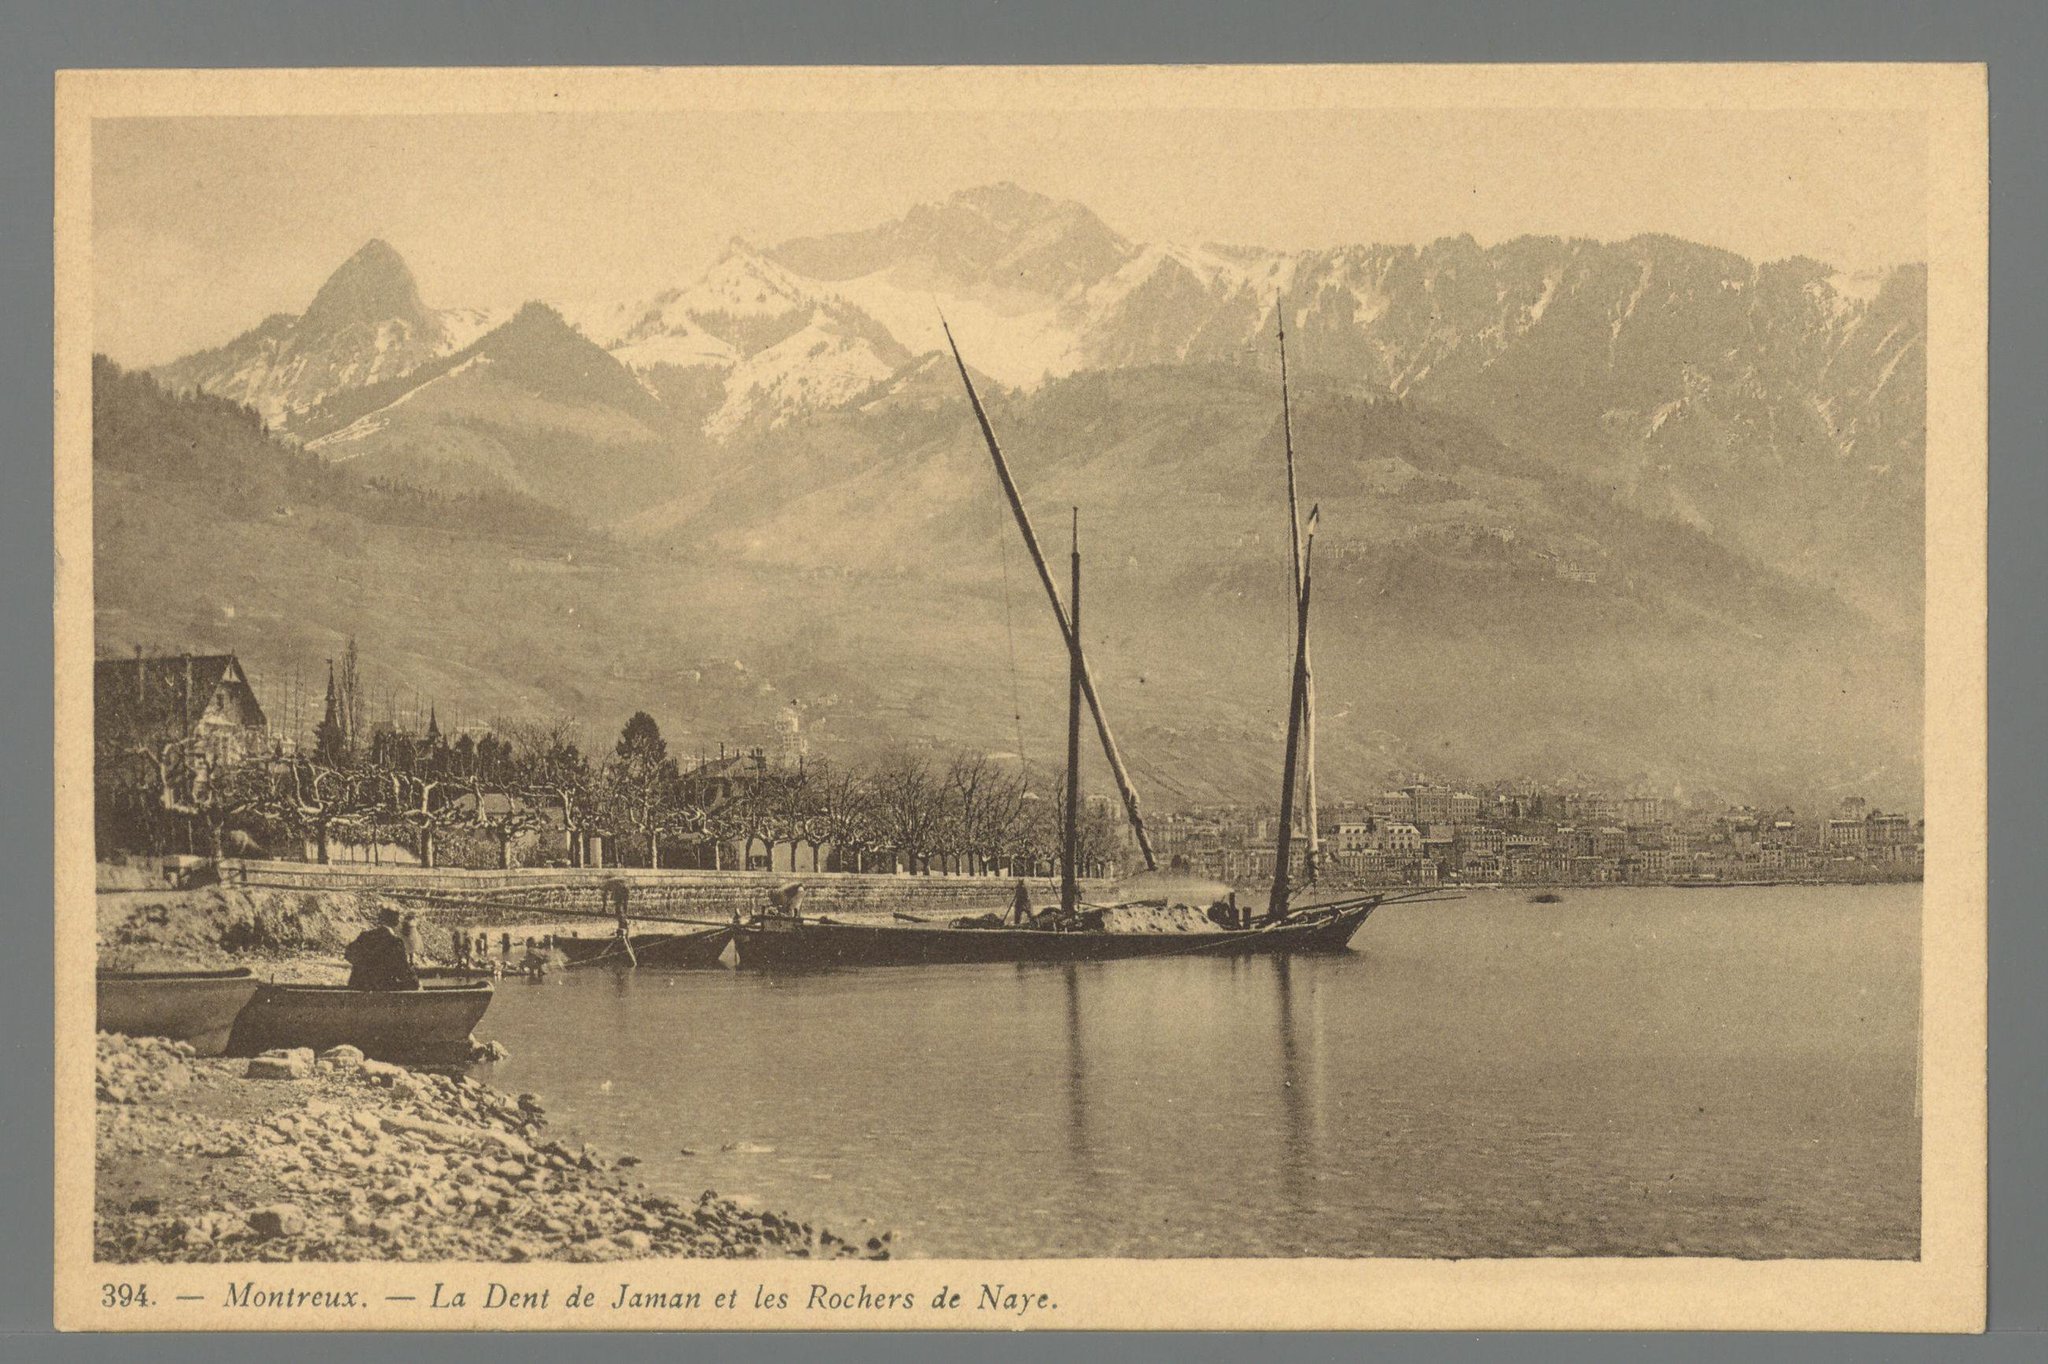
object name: ansichtkaart, prentbriefkaart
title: Montreux. La Dent de Jaman et les Rochers de Naye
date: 1905-1909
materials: cardboard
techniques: photograph, writing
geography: montreux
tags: ships (in general), lake, mountain-range, snow peaks